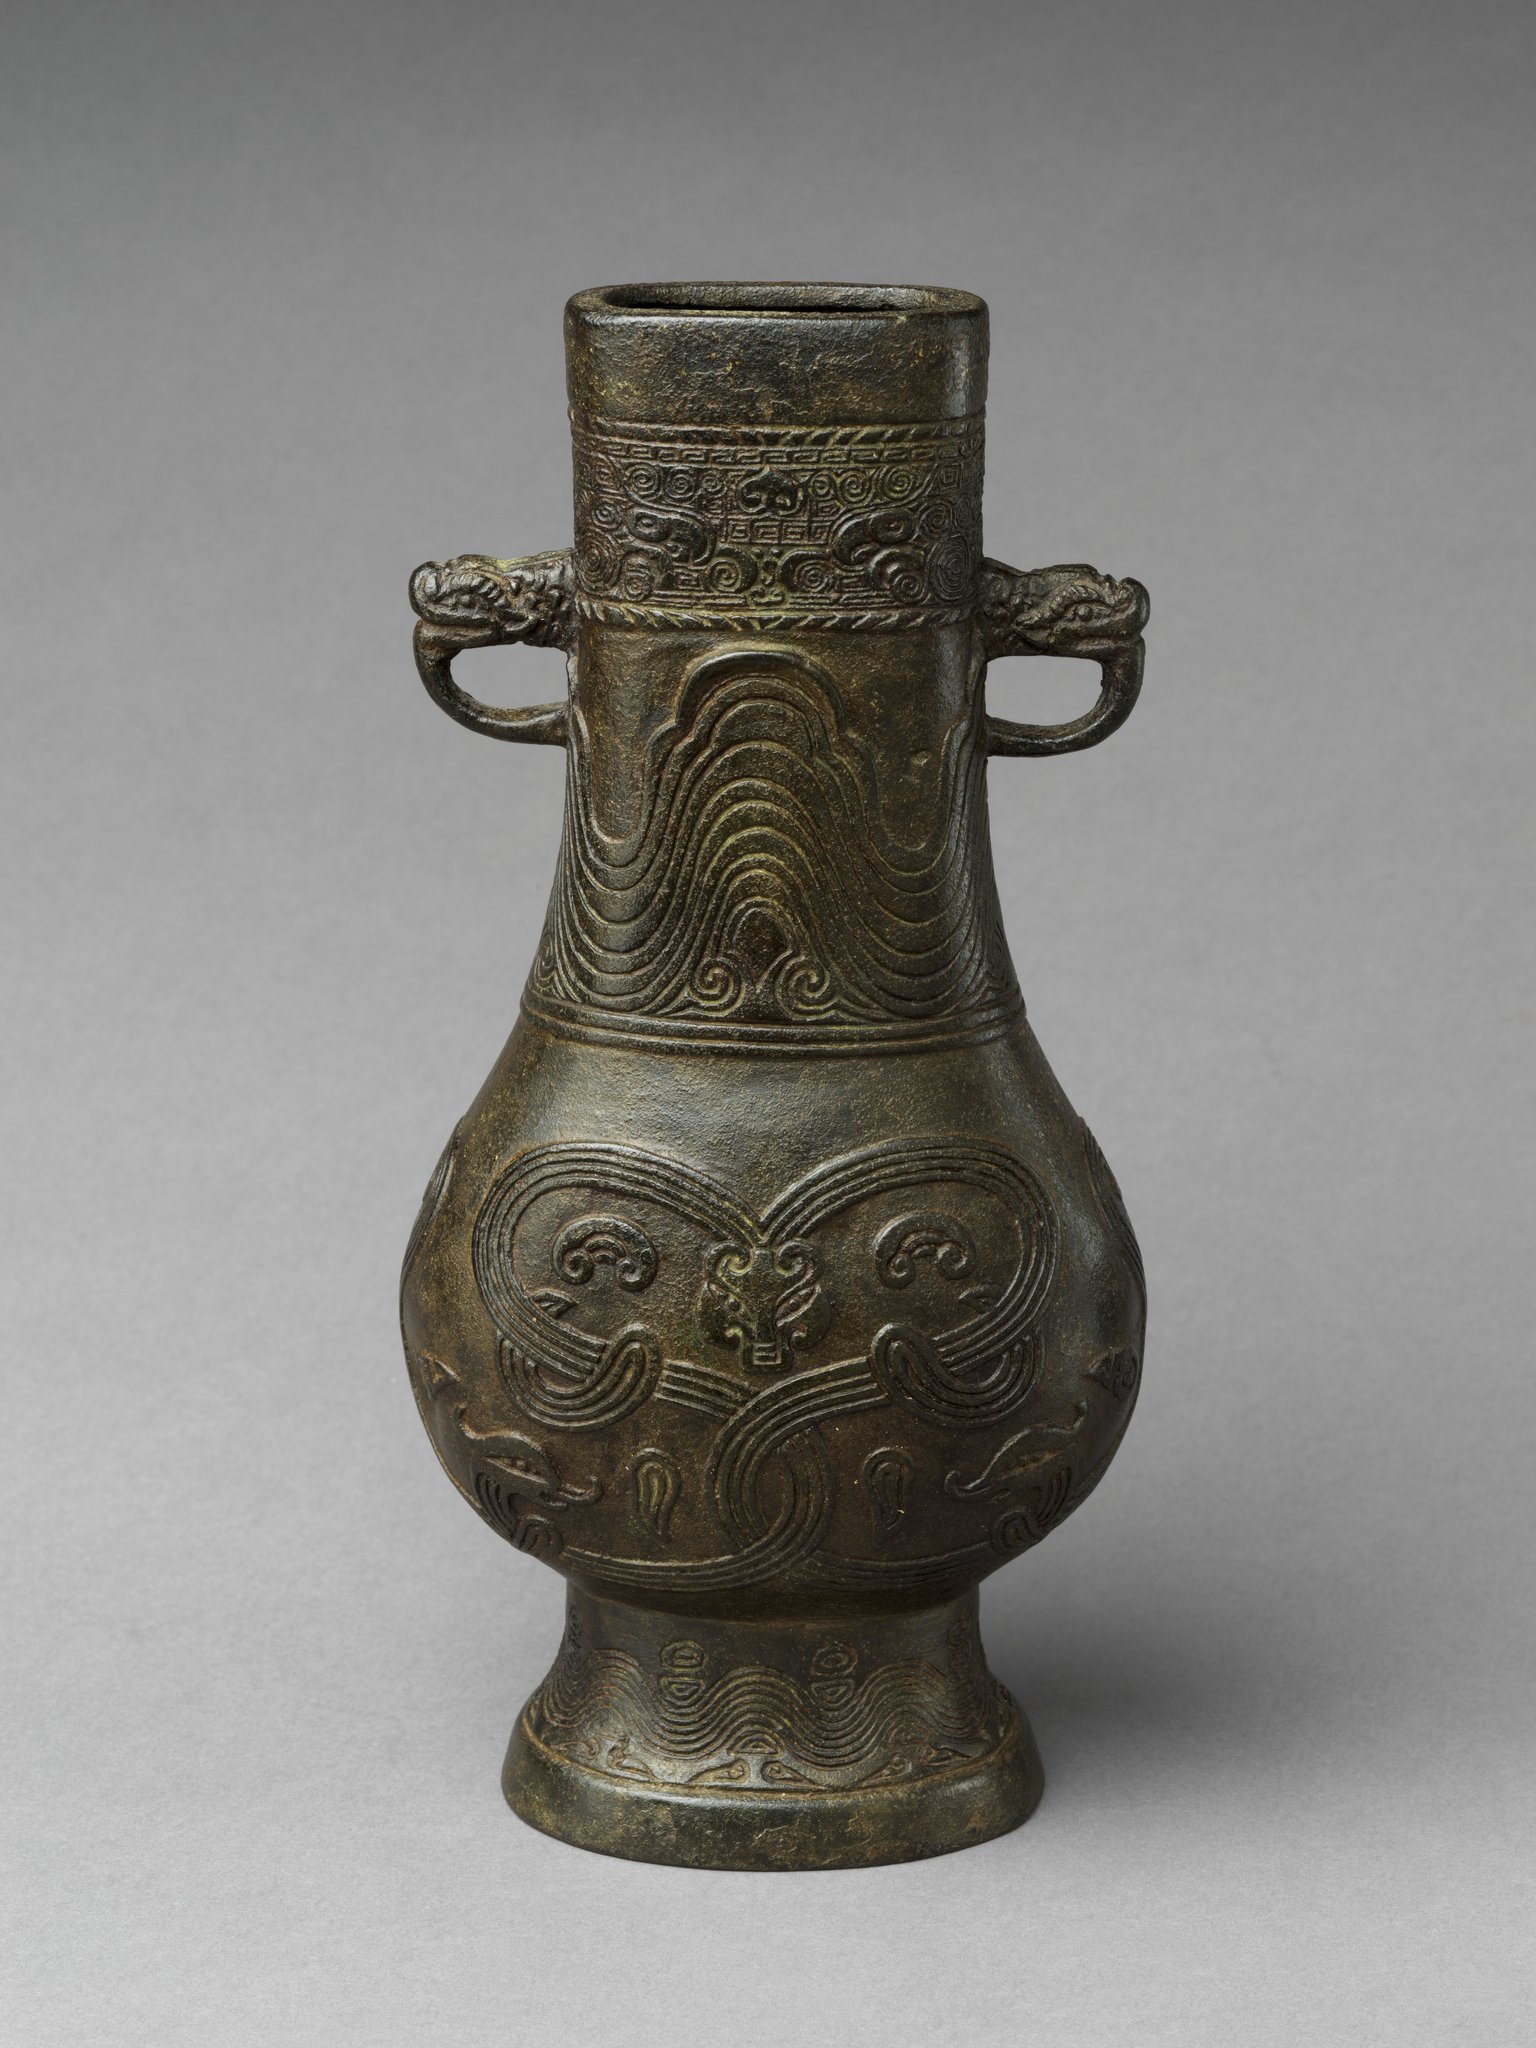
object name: vase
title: Flower vase with animal-head handles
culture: chinese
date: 1301-1400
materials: copper alloy